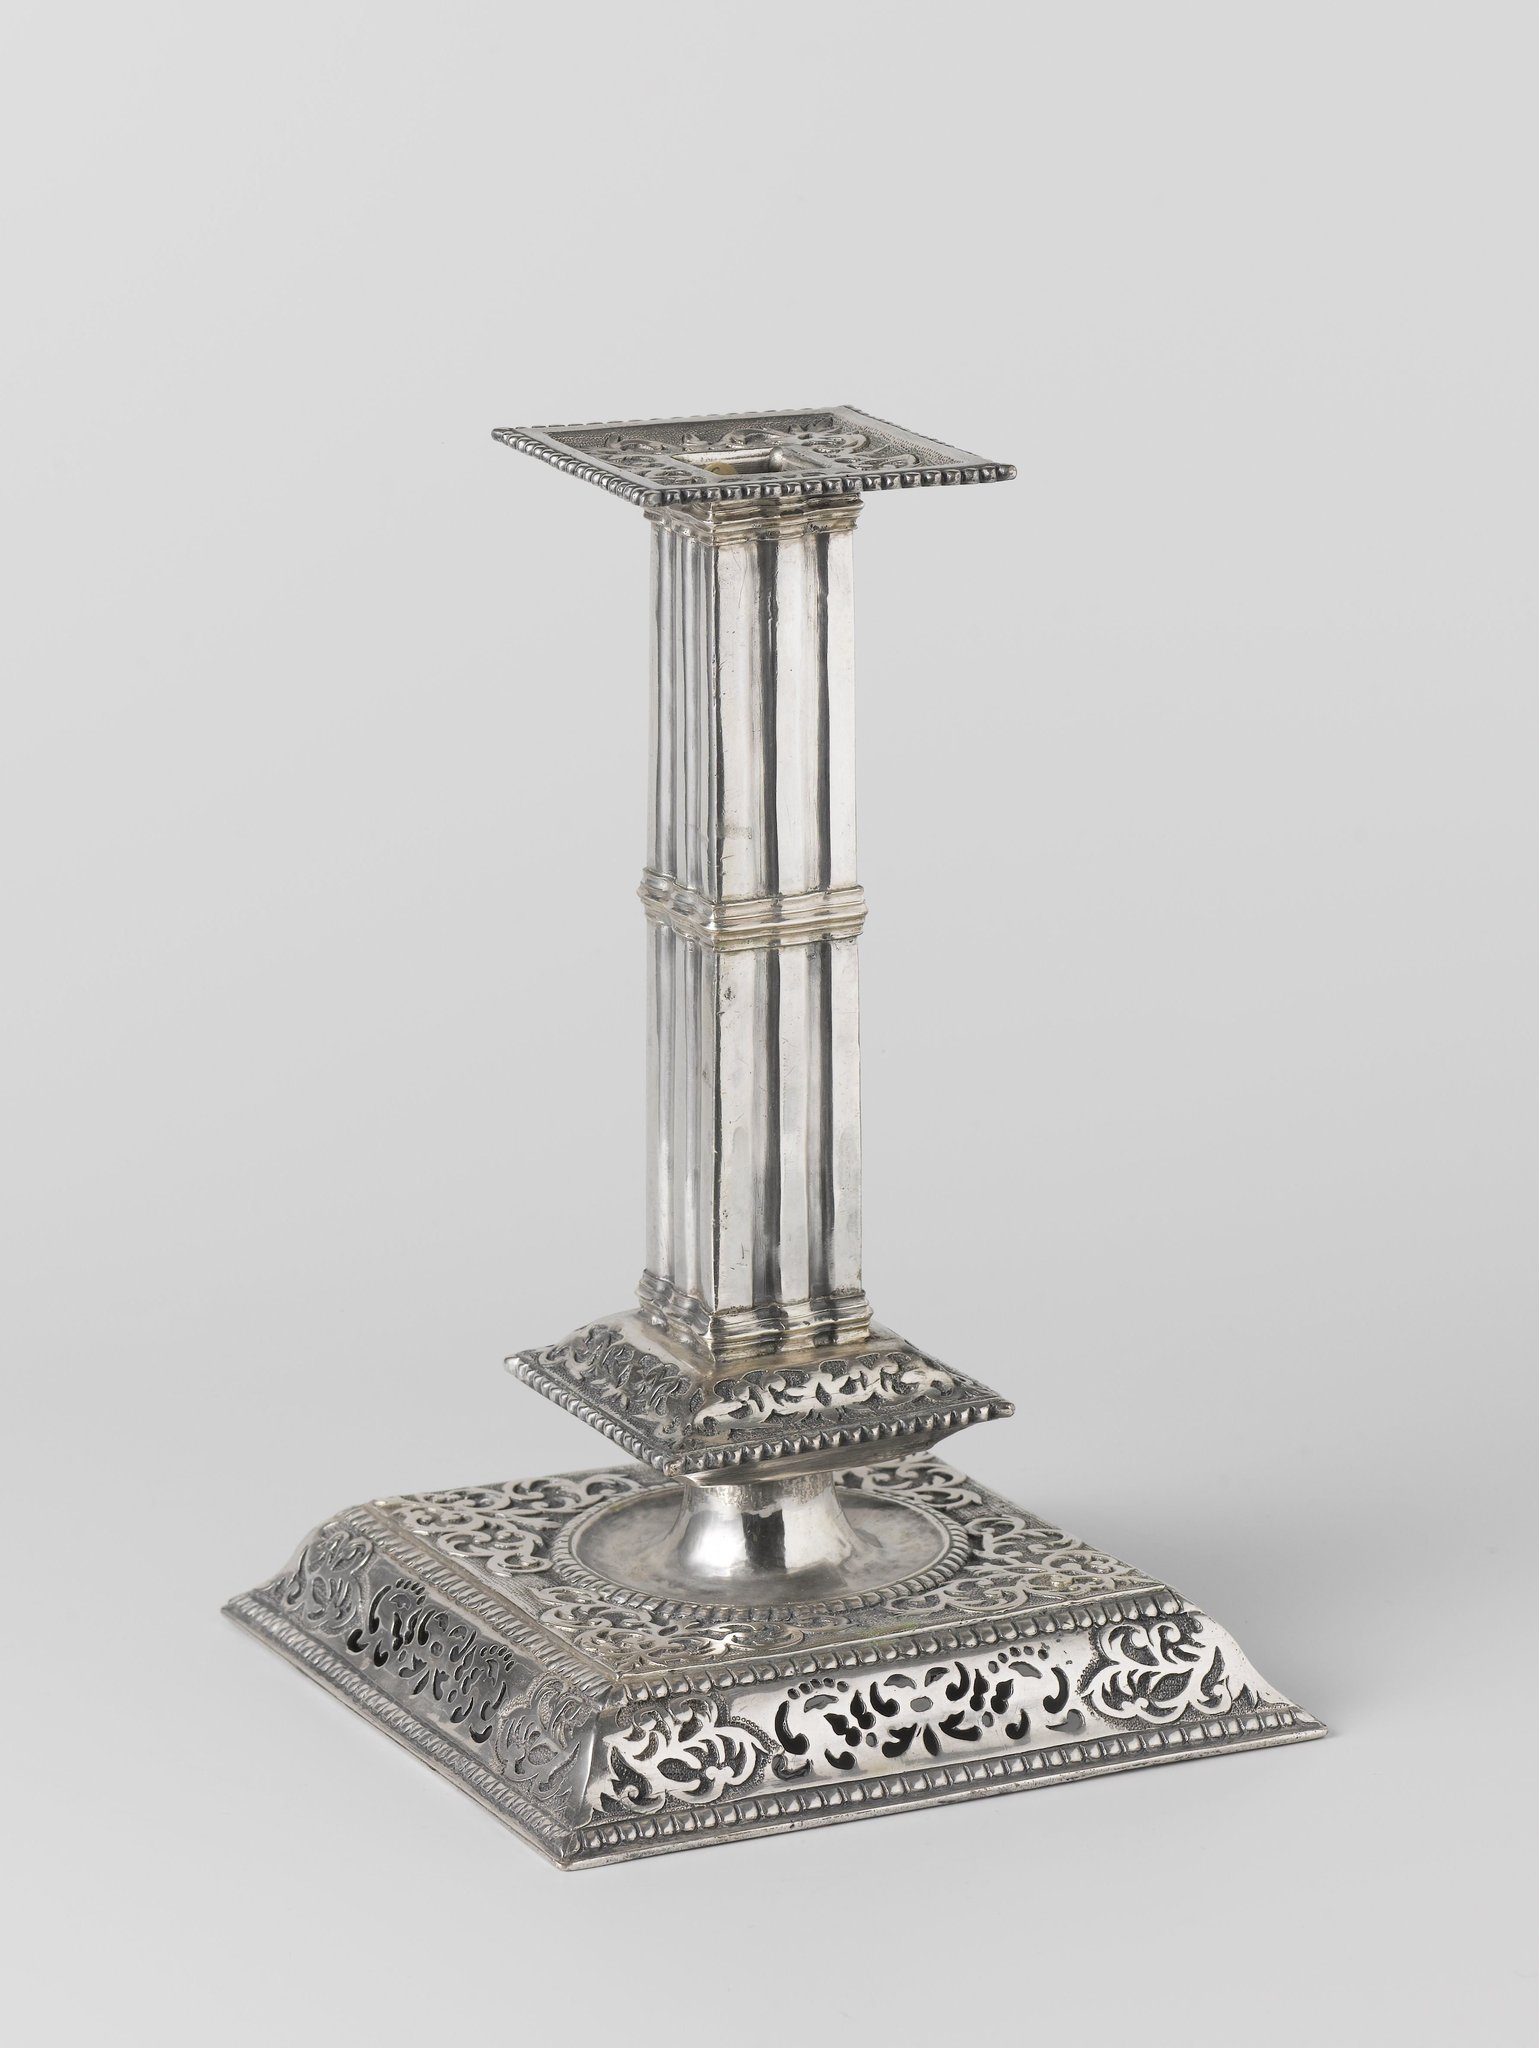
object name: candlestick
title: Pair of candlesticks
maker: jan van cloon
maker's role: silversmith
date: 1730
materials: silver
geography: batavia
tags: foliage, tendrils, branches ~ ornament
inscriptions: maker's mark: ‘IVC’, mark: ‘W’, town mark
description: In Batavia, Dutch silversmiths worked alongside Chinese, Indian and local craftsmen. These candlesticks bear the hallmarks of Batavia and the marks of a master IVC, possibly Jan van Cloon. His candlesticks have no Asian features and closely follow European models.